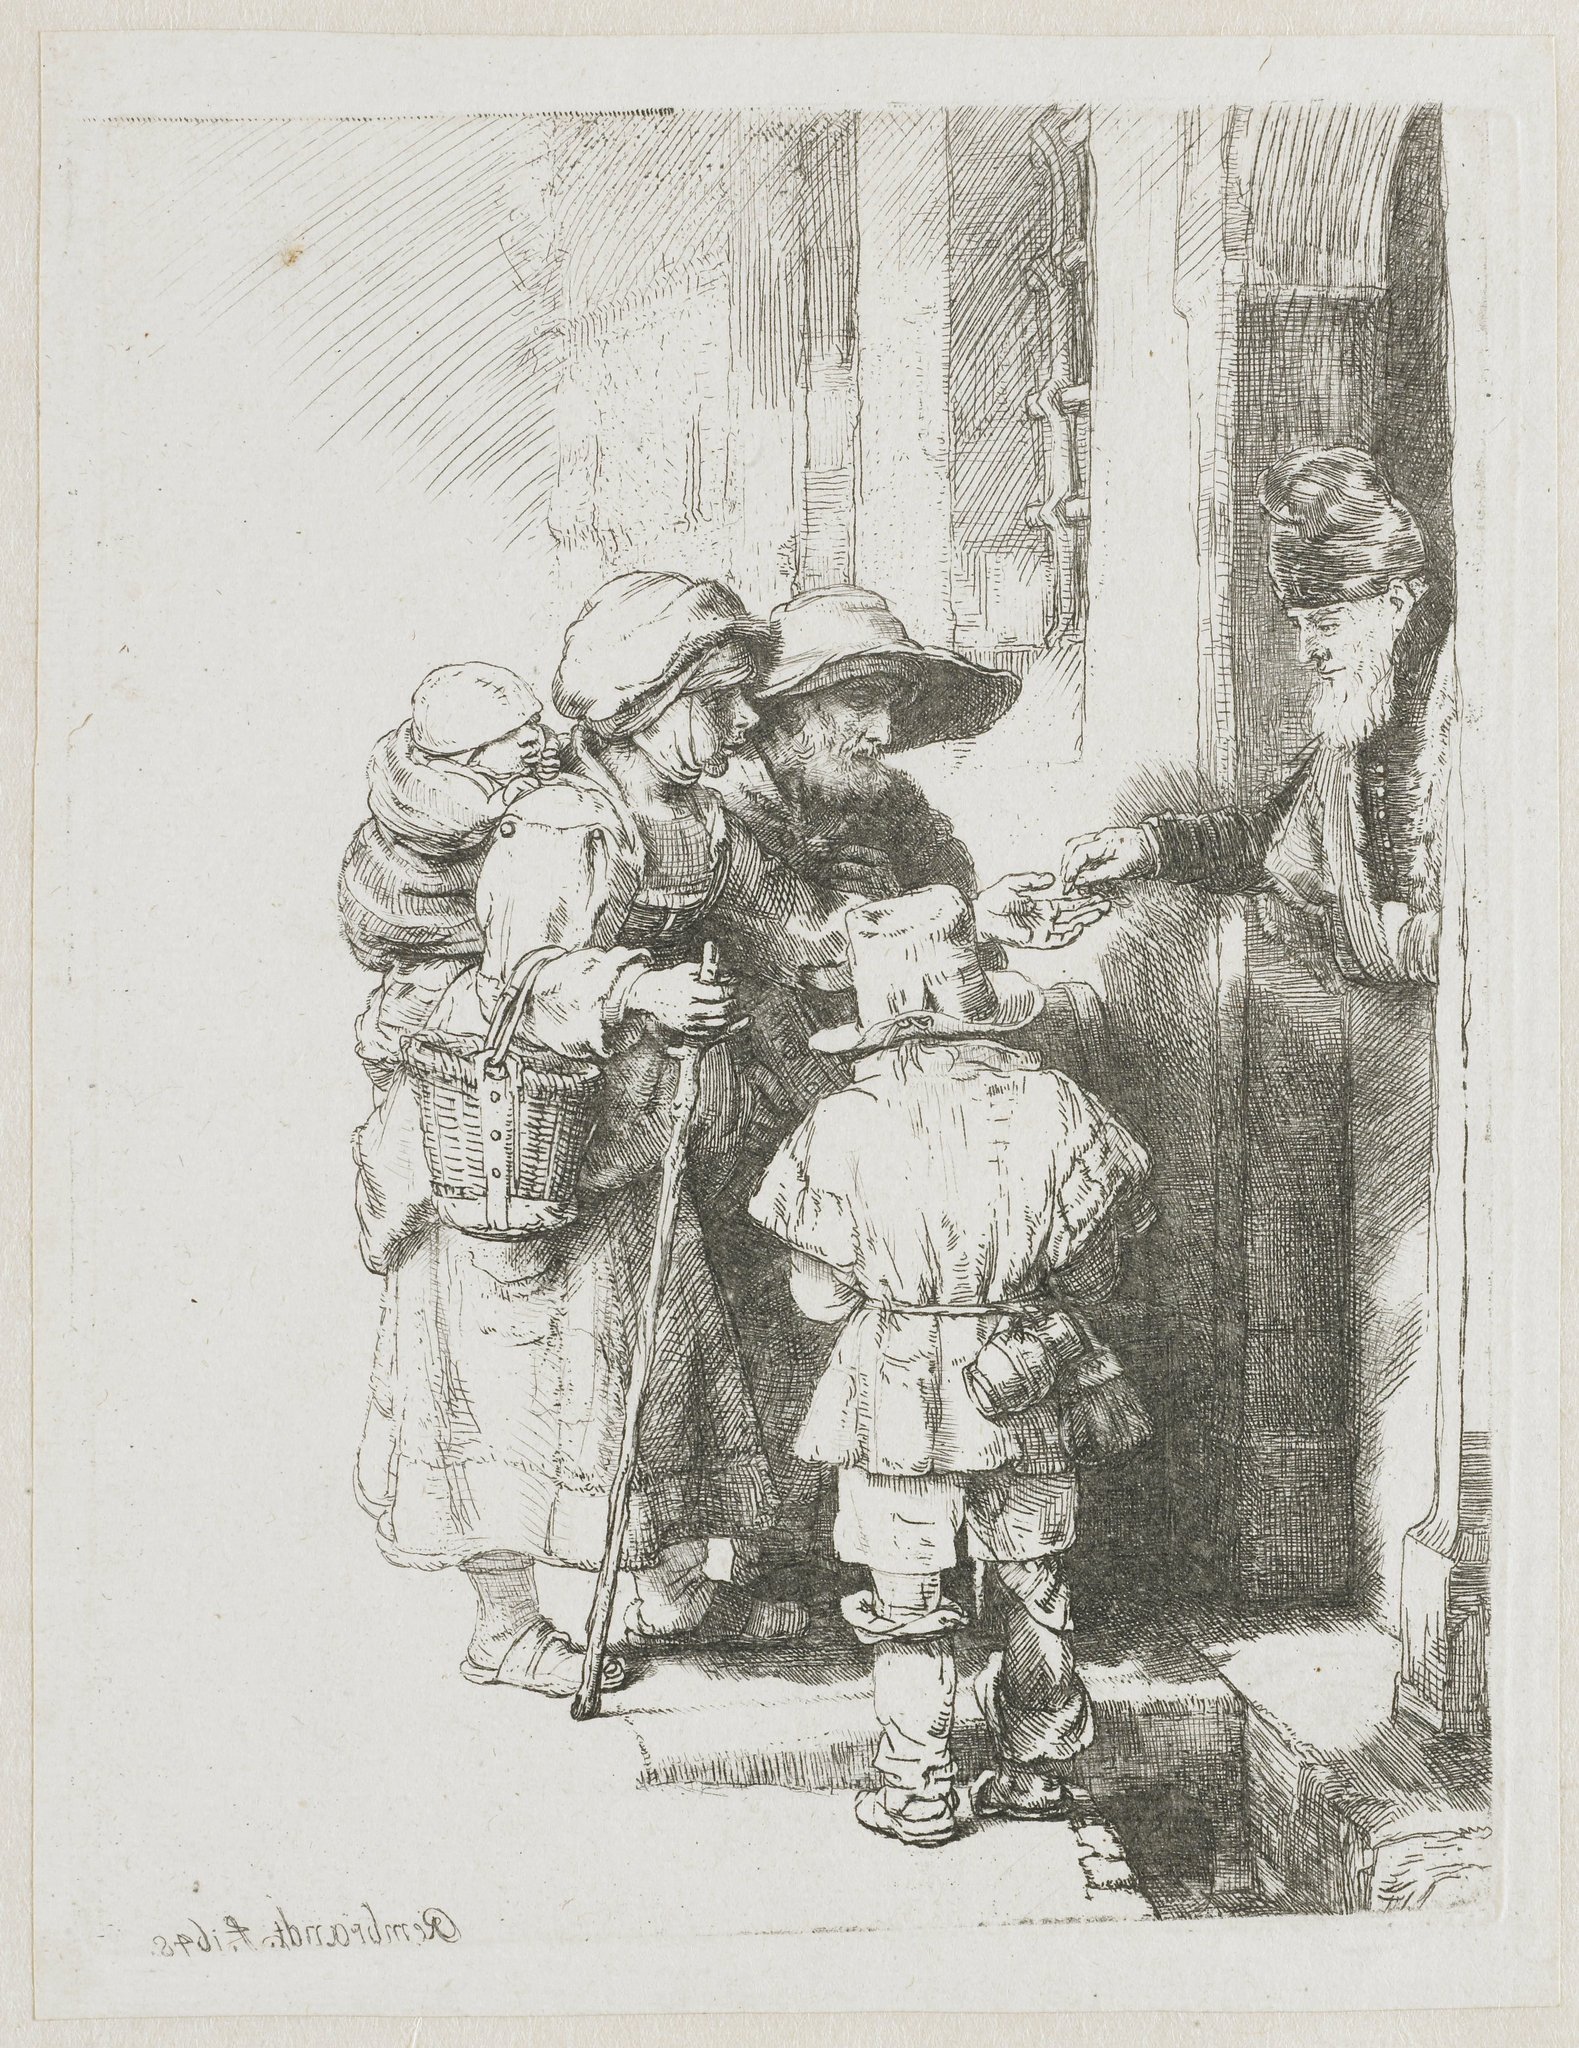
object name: print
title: A blind hurdy-gurdy player and family receiving alms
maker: rembrandt van rijn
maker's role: draughtsman, painter, print maker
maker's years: 1606-1669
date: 1648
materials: paper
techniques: printmaking, drypoint, etching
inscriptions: signature and date: ‘Rembrandt f. 1648 (spiegelbeeldig)’, collector's mark: Lugt 240